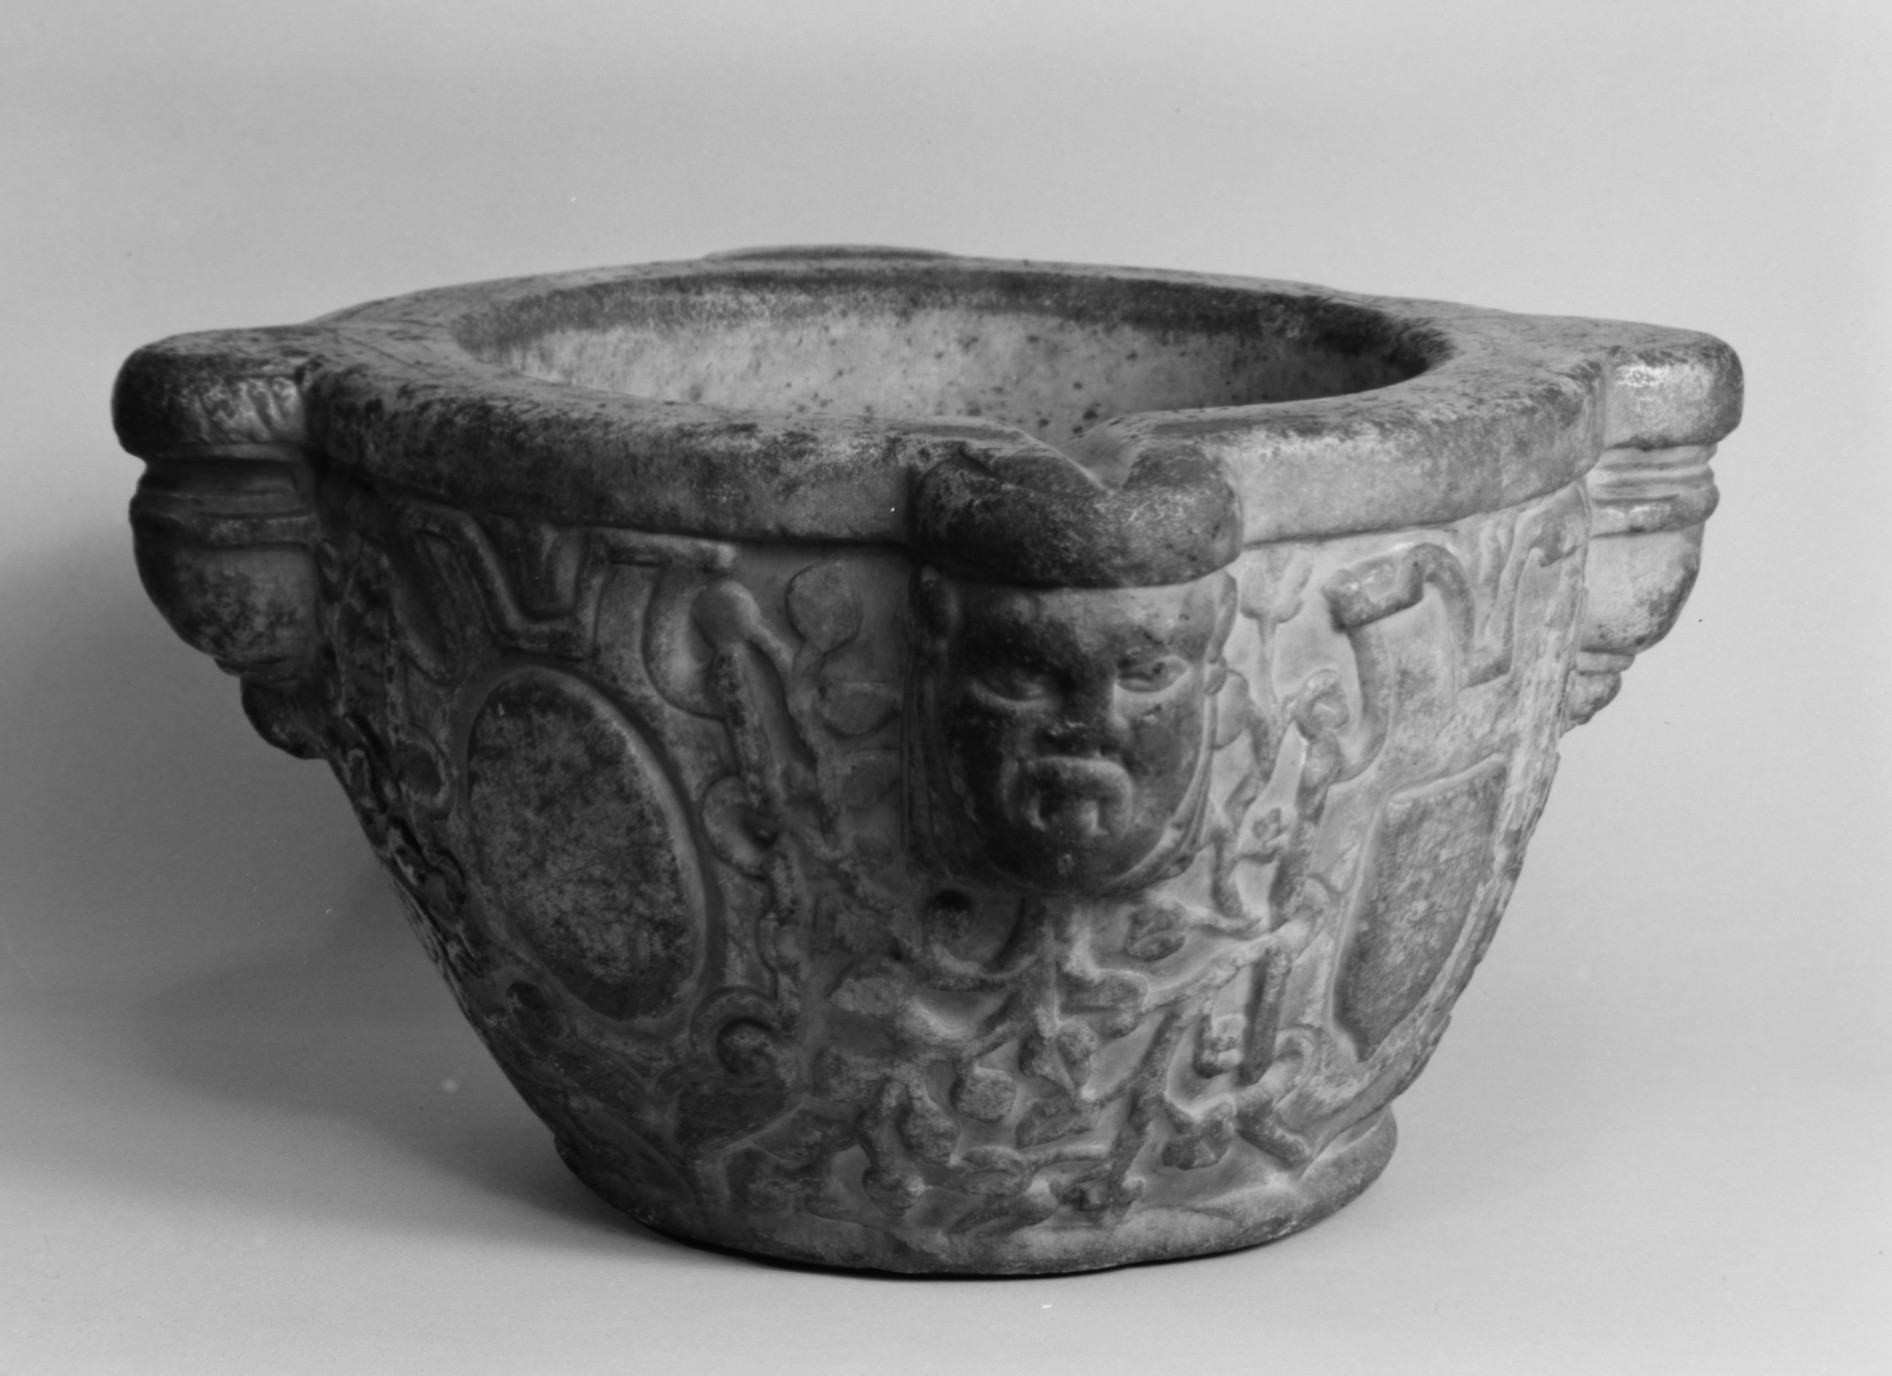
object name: mortar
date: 1601-1800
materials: marble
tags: heads